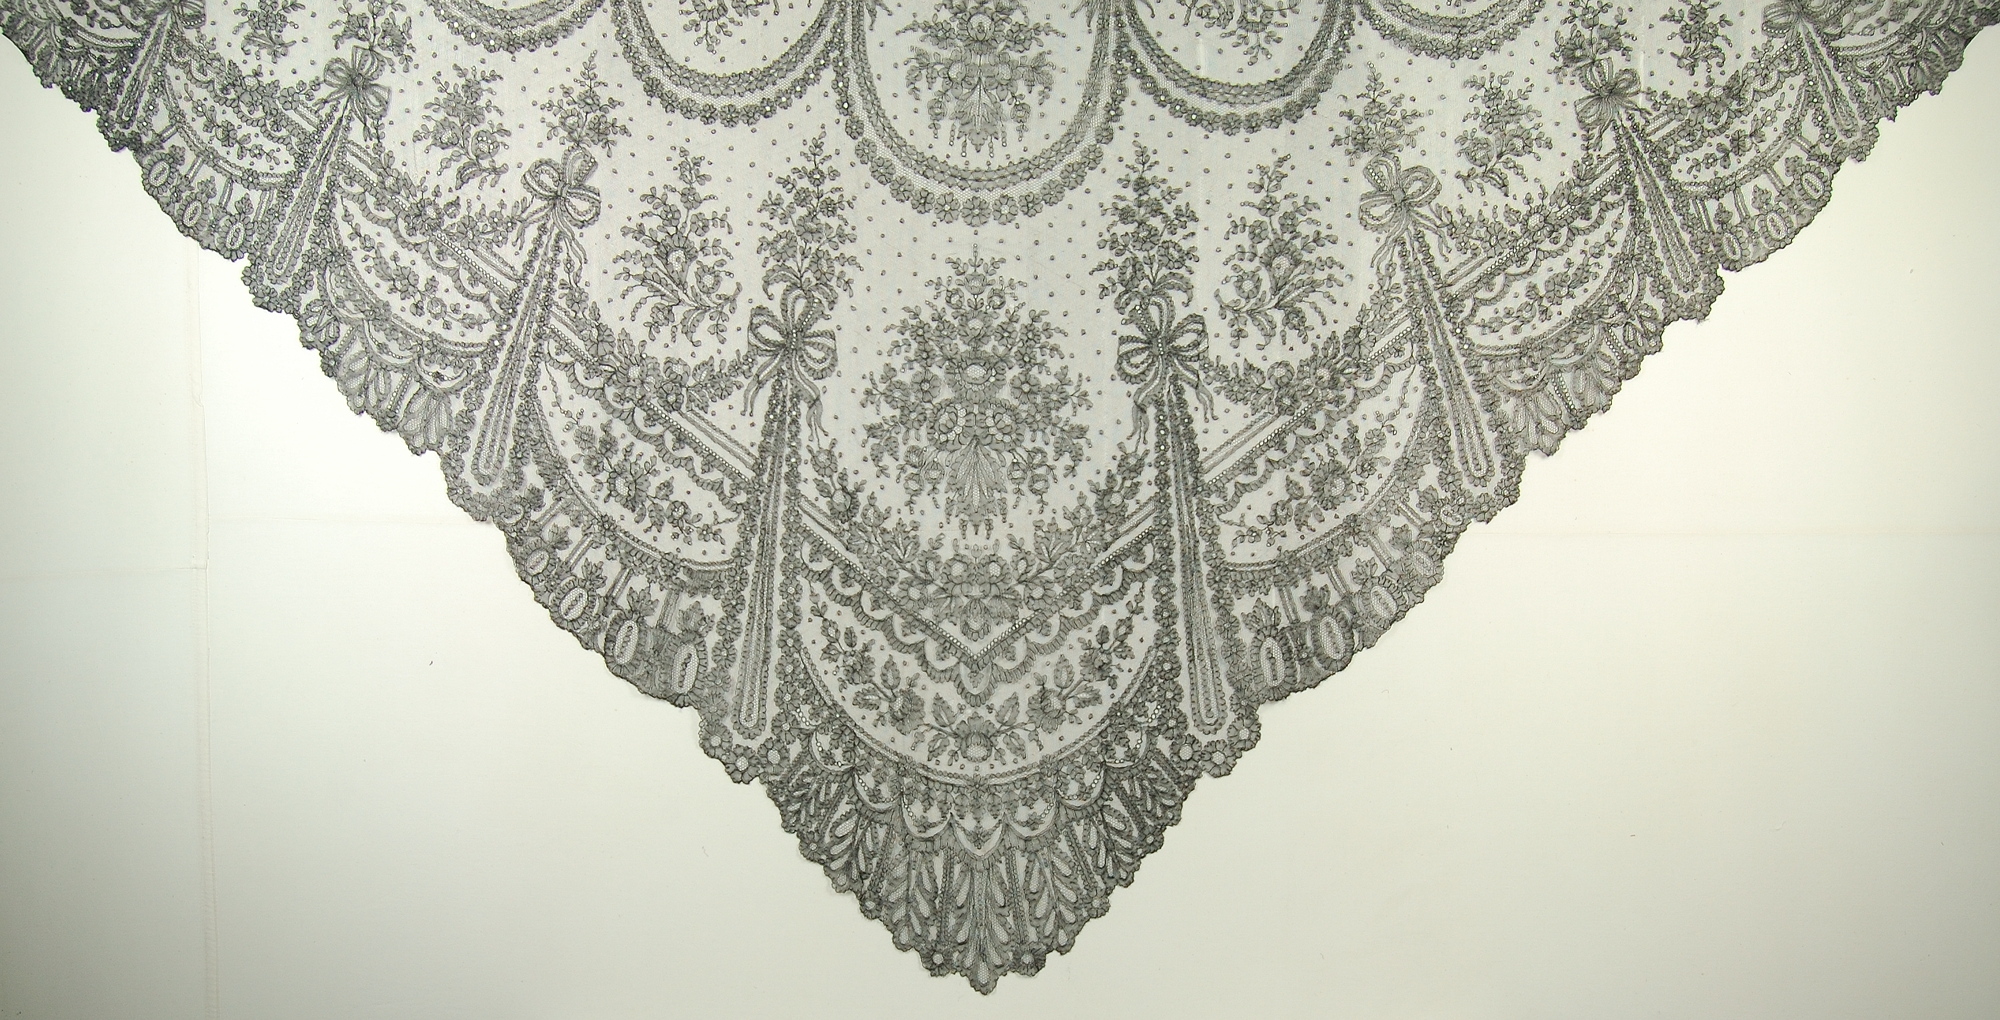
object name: shawl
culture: french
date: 1860-1870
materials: silk